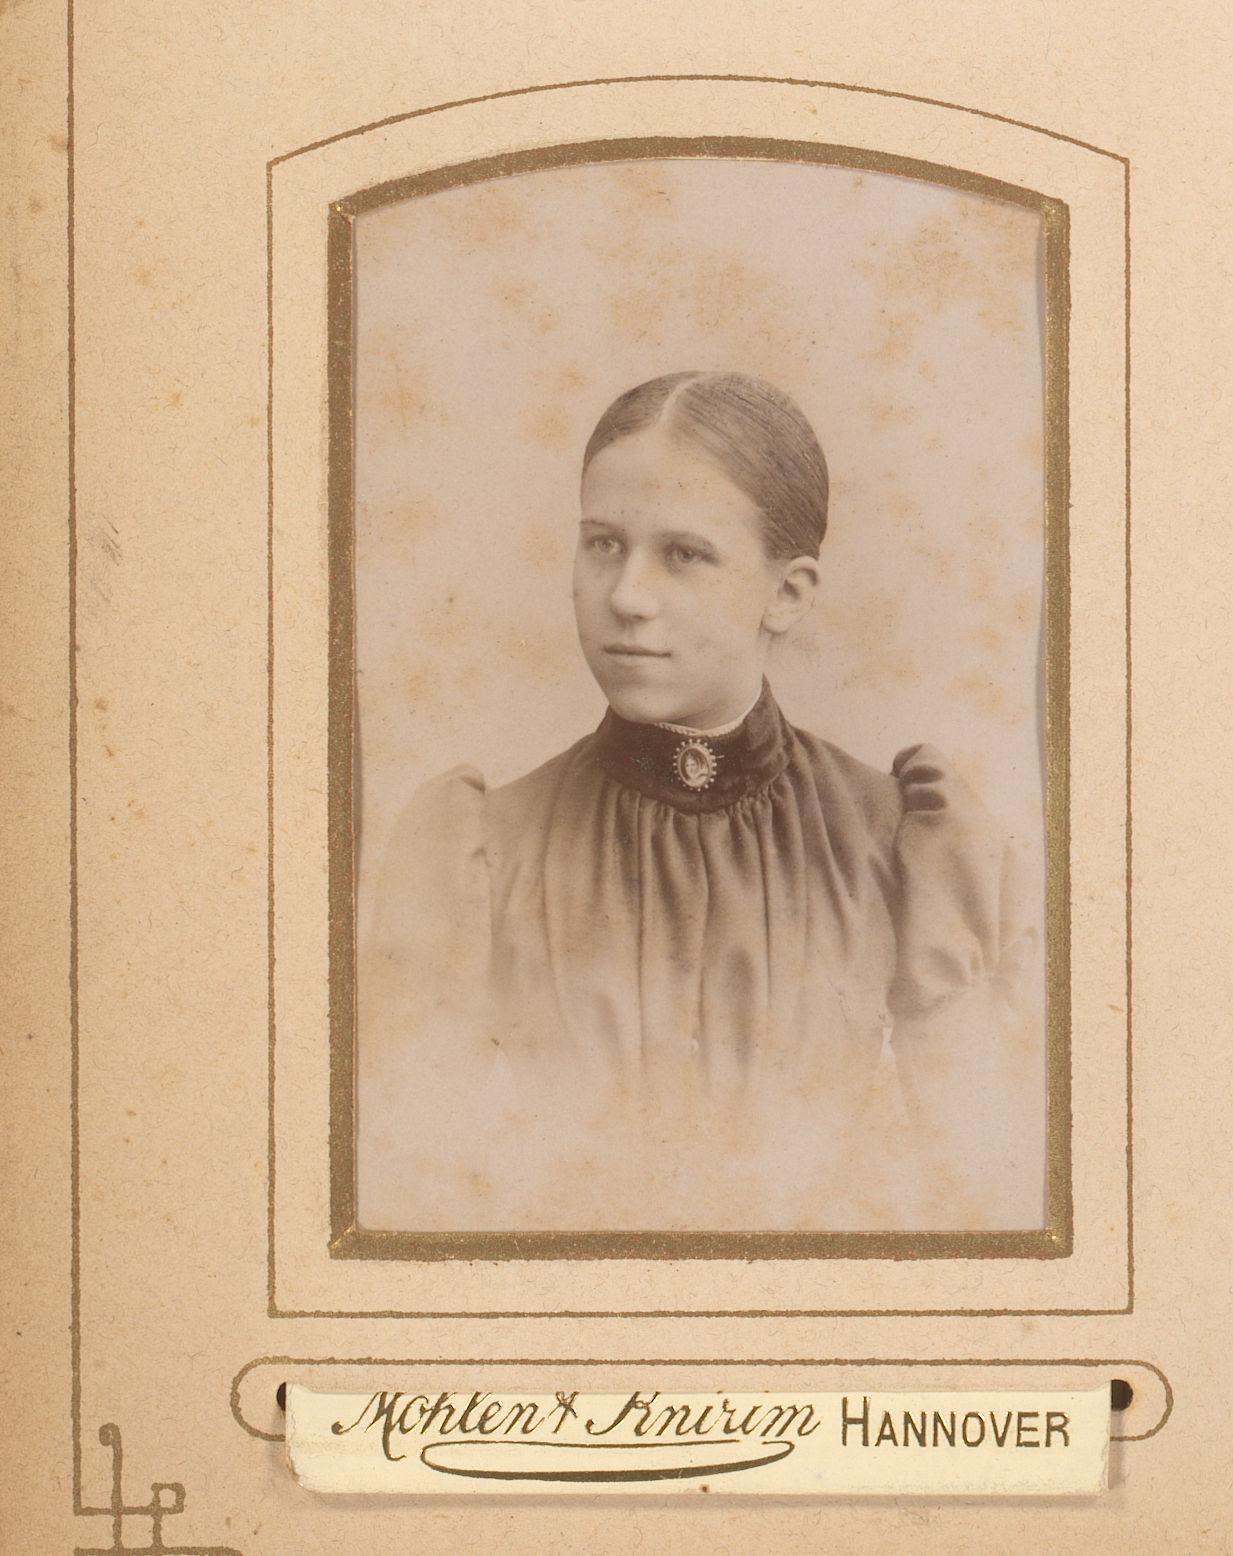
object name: carte de visite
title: Portret van een meisje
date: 1880-1900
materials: cardboard, photographic support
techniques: albumen print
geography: hannover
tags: historical persons - bb - woman, girl (child between toddler and youth)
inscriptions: inscription: ‘Möhlen & Knirim/ Hannover’